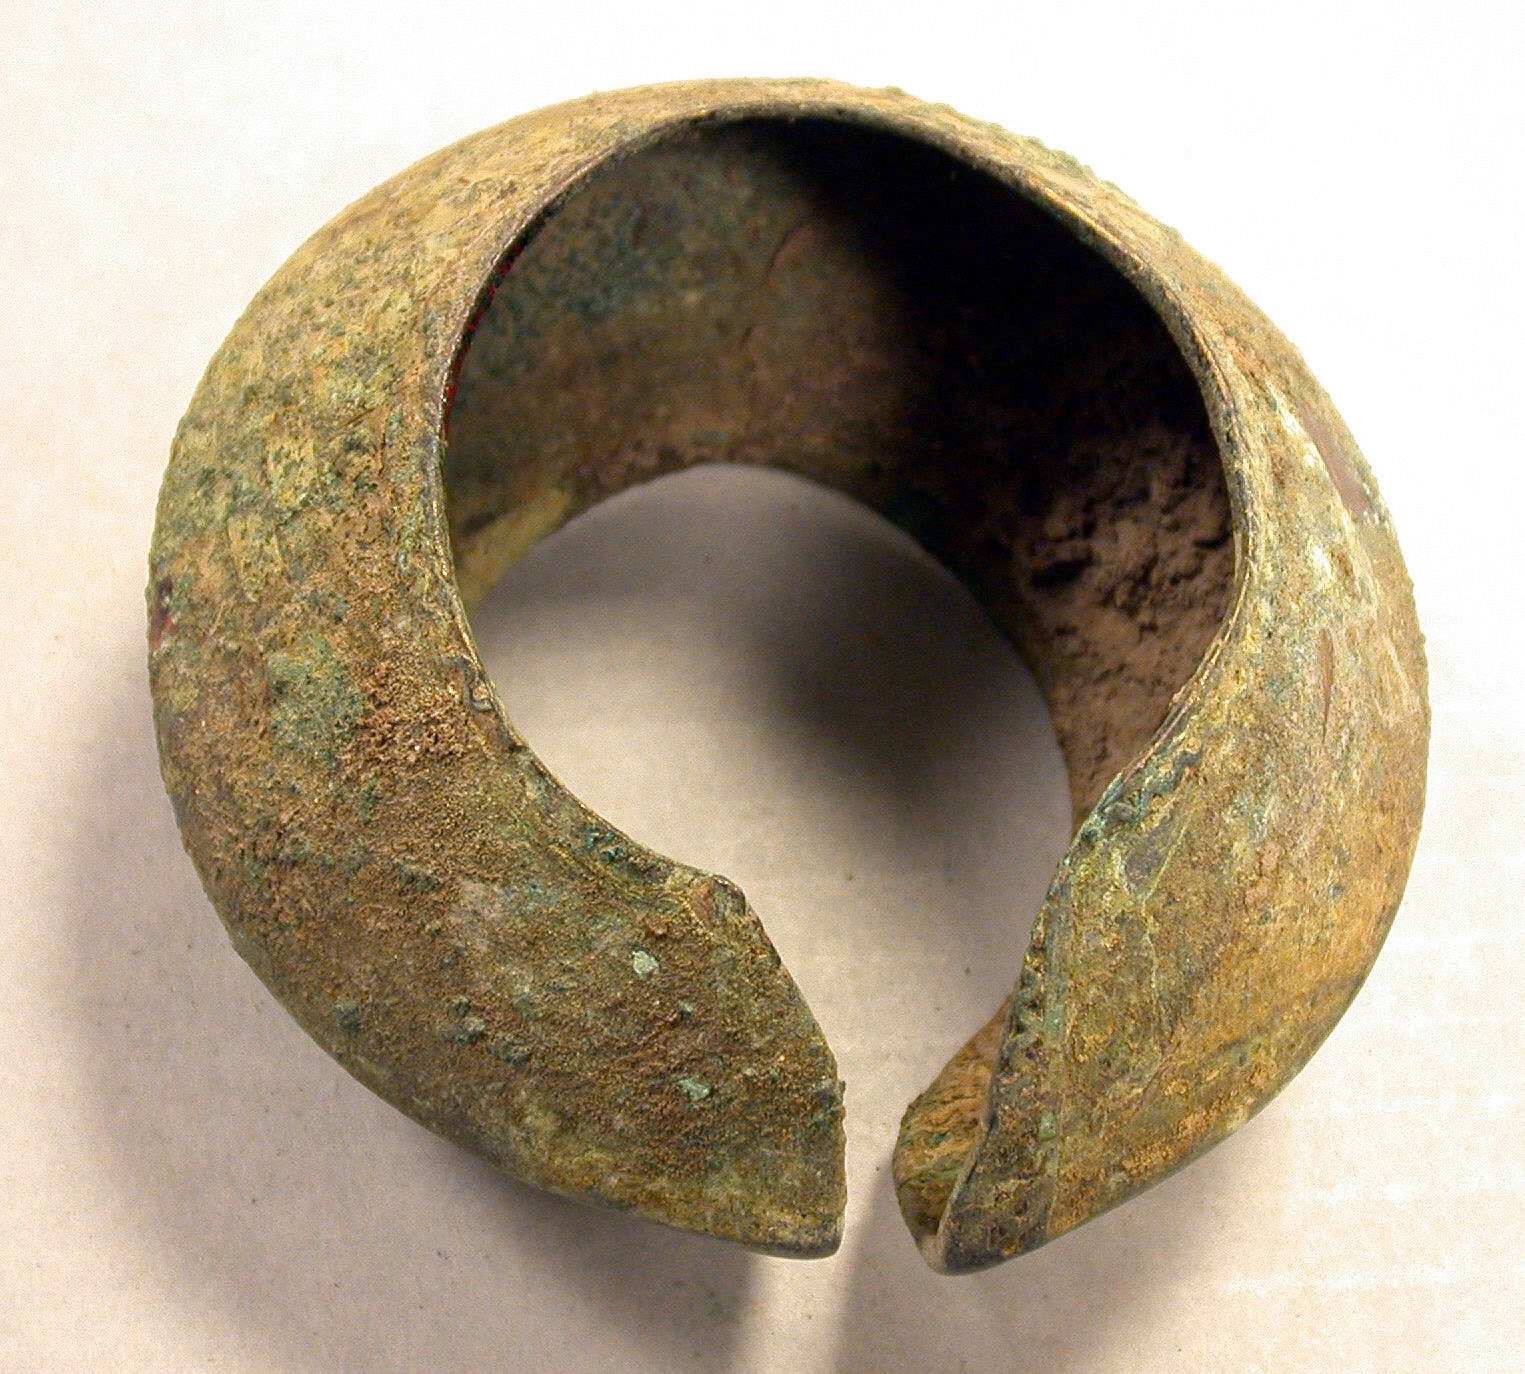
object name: bracelet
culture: middle niger civilization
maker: middle niger artist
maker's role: artist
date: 1001-1600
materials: copper alloy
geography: mali